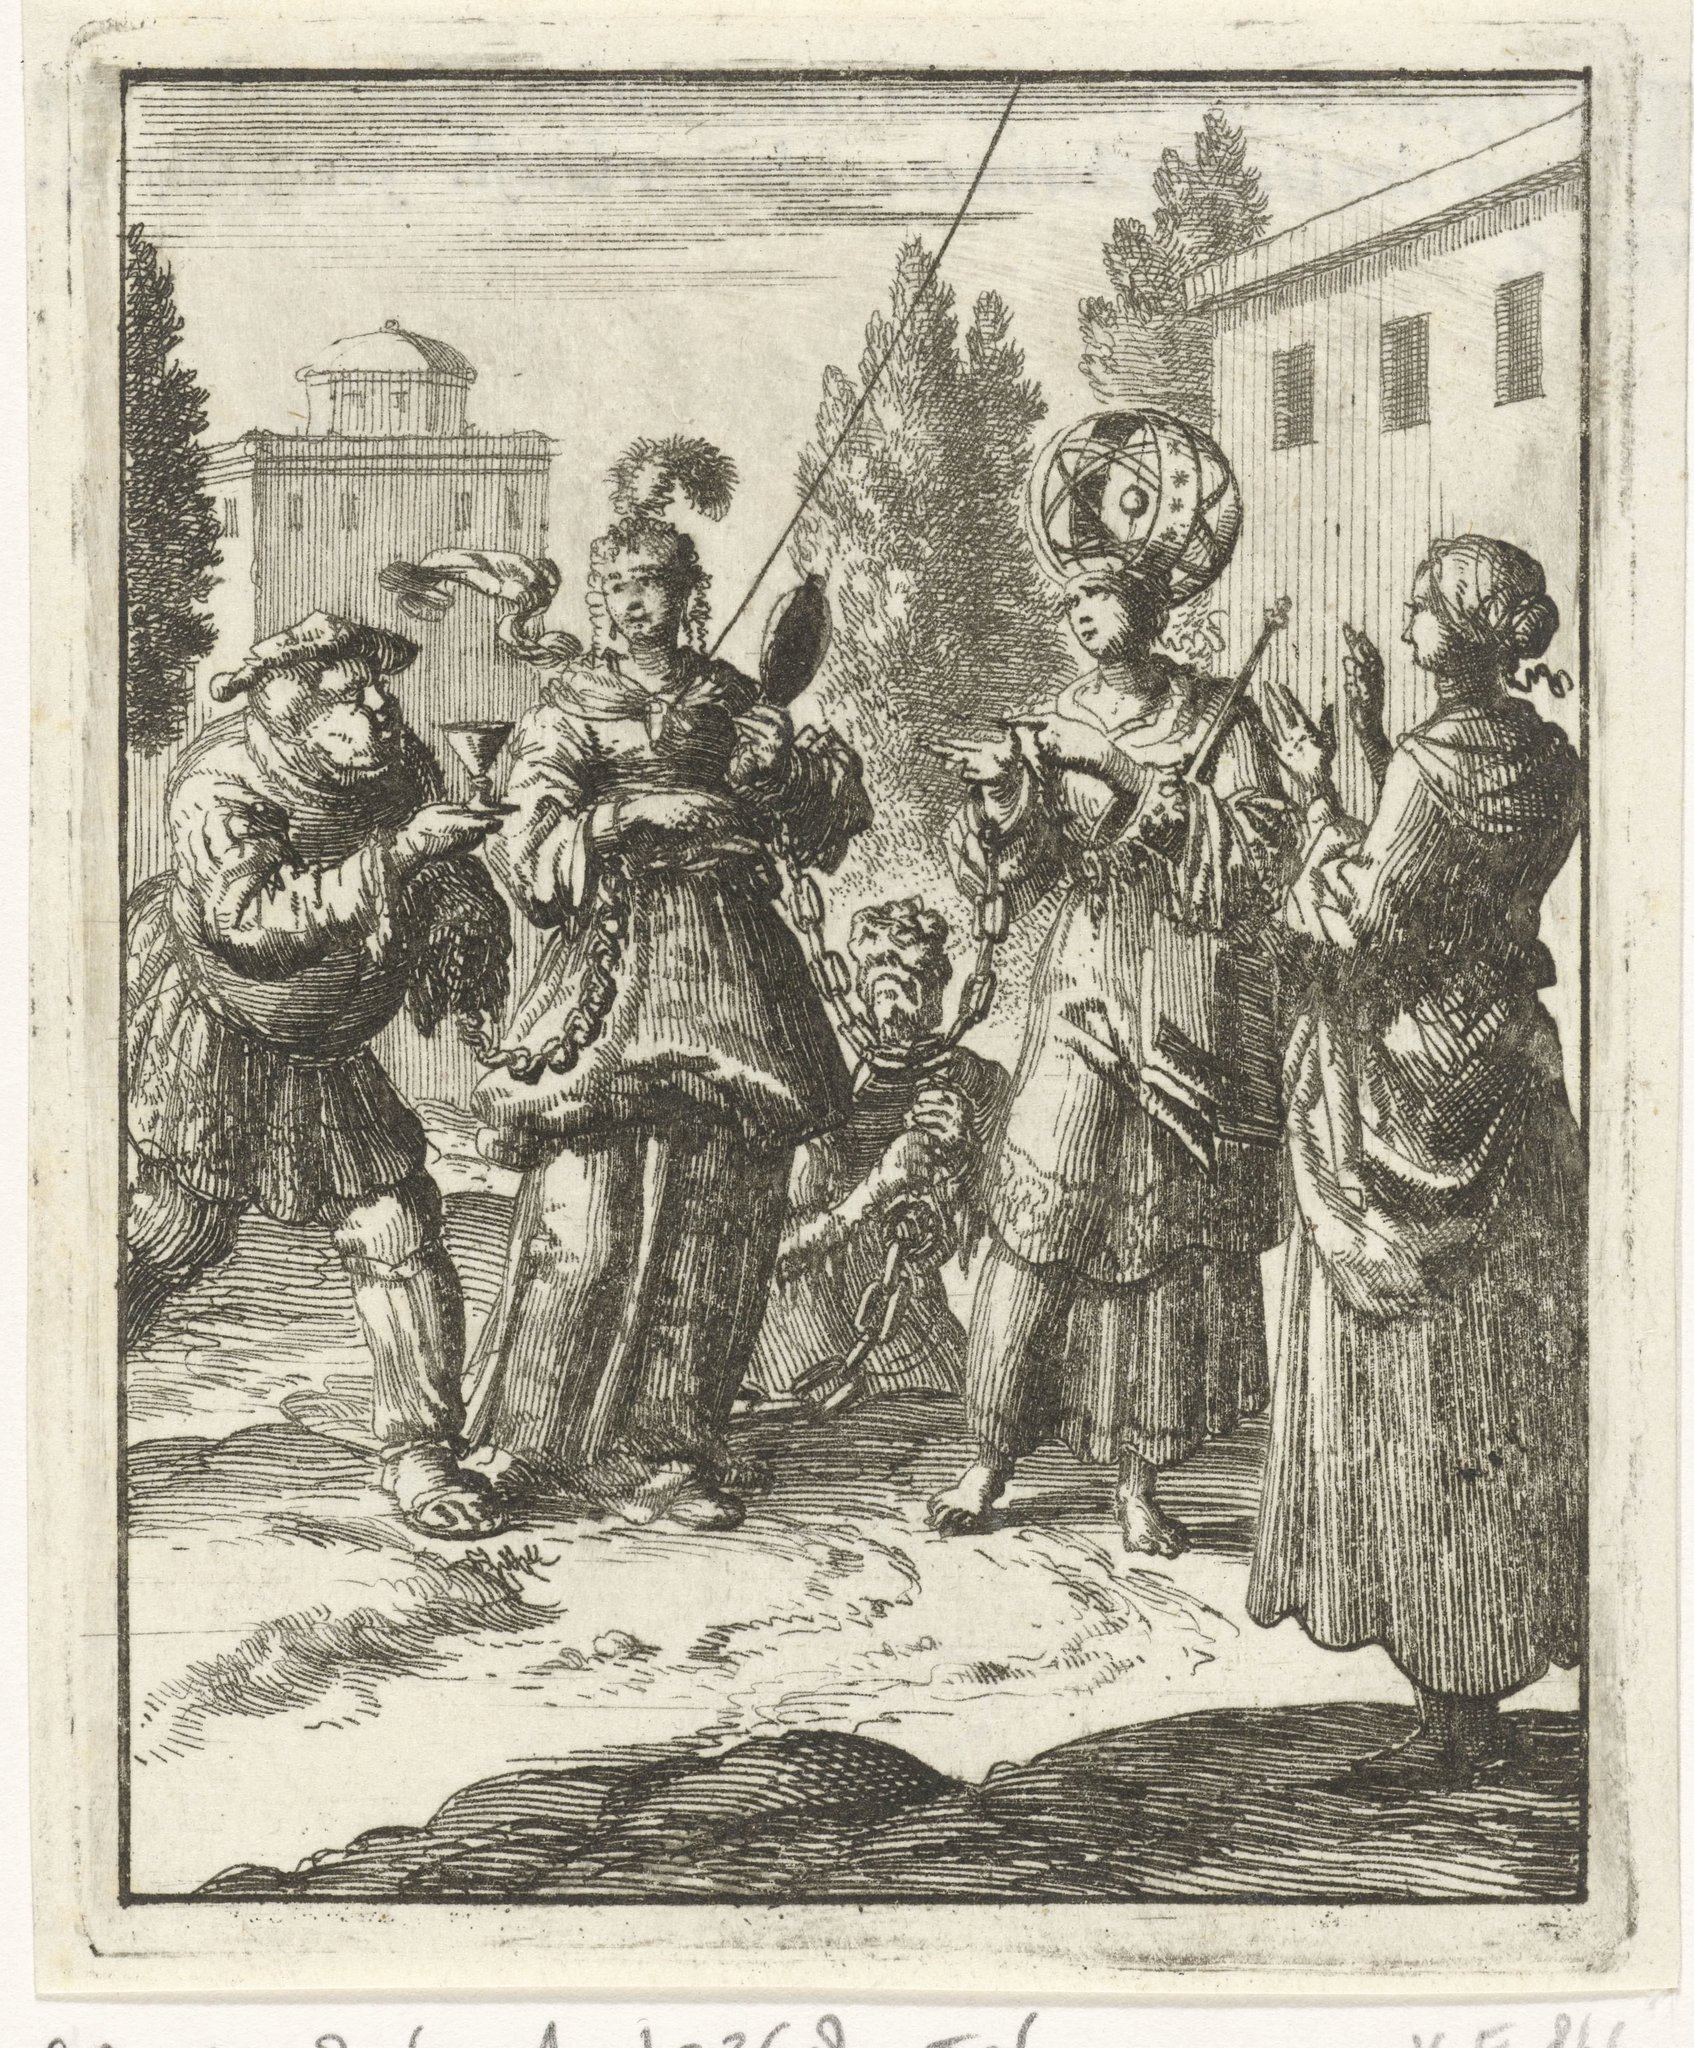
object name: book illustration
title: O Goude vryheyt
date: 1687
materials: paper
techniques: etching, letterpress printing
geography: amsterdam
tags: lust, luxury, 'luxuria'; 'lussuria' (ripa) ~ personification of one of the deadly sins, devil(s) and demons, 'mondo', 'machina del mondo' (ripa)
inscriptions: collector's mark: Lugt 2228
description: Illustratie uit: Luyken, Jan. Voncken der liefde Jesu, van het godtbegerende zielenvier. Amsterdam: Pieter Arentsz (II), 1687, p. 128.